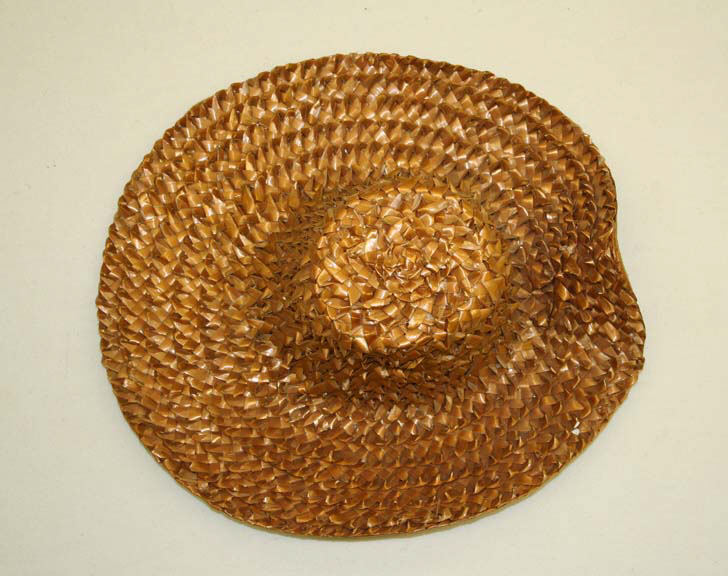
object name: hat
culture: american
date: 1885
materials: fiber